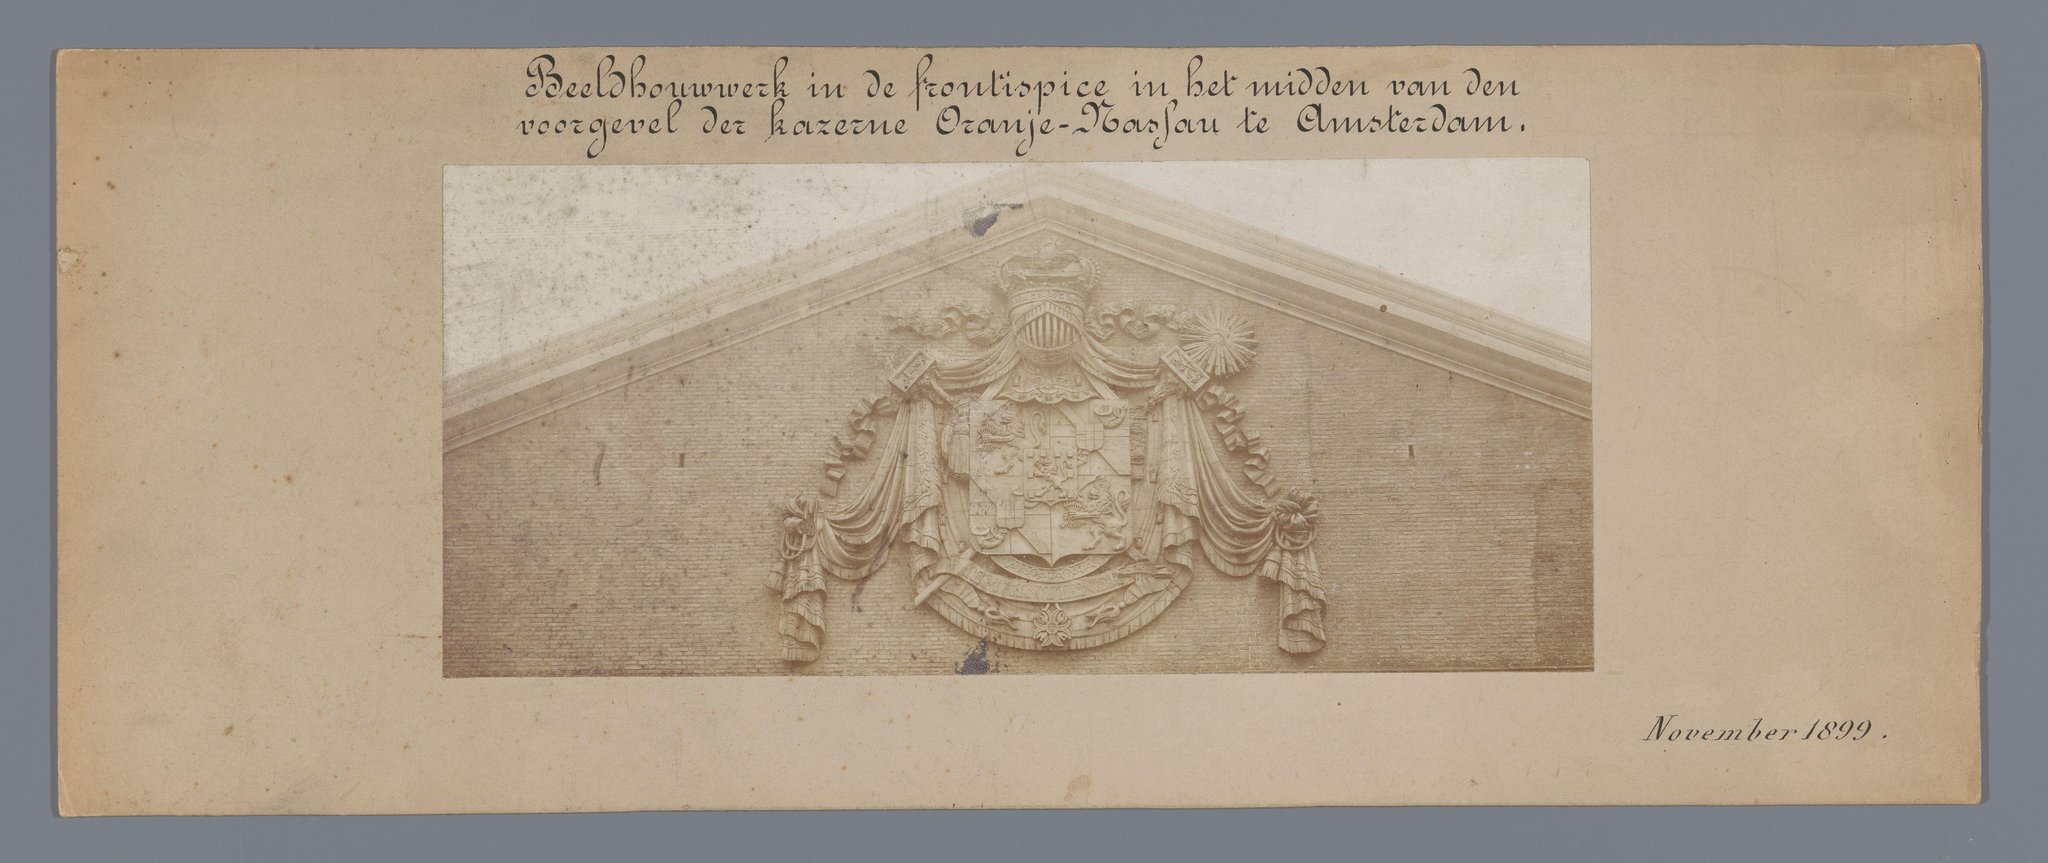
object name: photograph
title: Reliëf op de voorgevel van de Oranje-Nassaukazerne te Amsterdam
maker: Anonymous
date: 1811-1899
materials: photographic support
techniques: collodion silver print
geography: amsterdam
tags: façade (of house or building), barracks, sculpture (+ relief ~ sculpture)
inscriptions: collector's mark: ‘Instituut voor kunst-nijverheidsonderwijs Gabriël Metsustraat No. 16, Amsterdam’, inscription: ‘Beeldhouwwerk in de frontispice in het midden van den voorgevel der kazerne Oranje-Nassau te Amsterdam/ November 1899’, collector's mark: ‘Kunstnijverheidschool Quellinus Amsterdam Frans Halsstraat 14.’